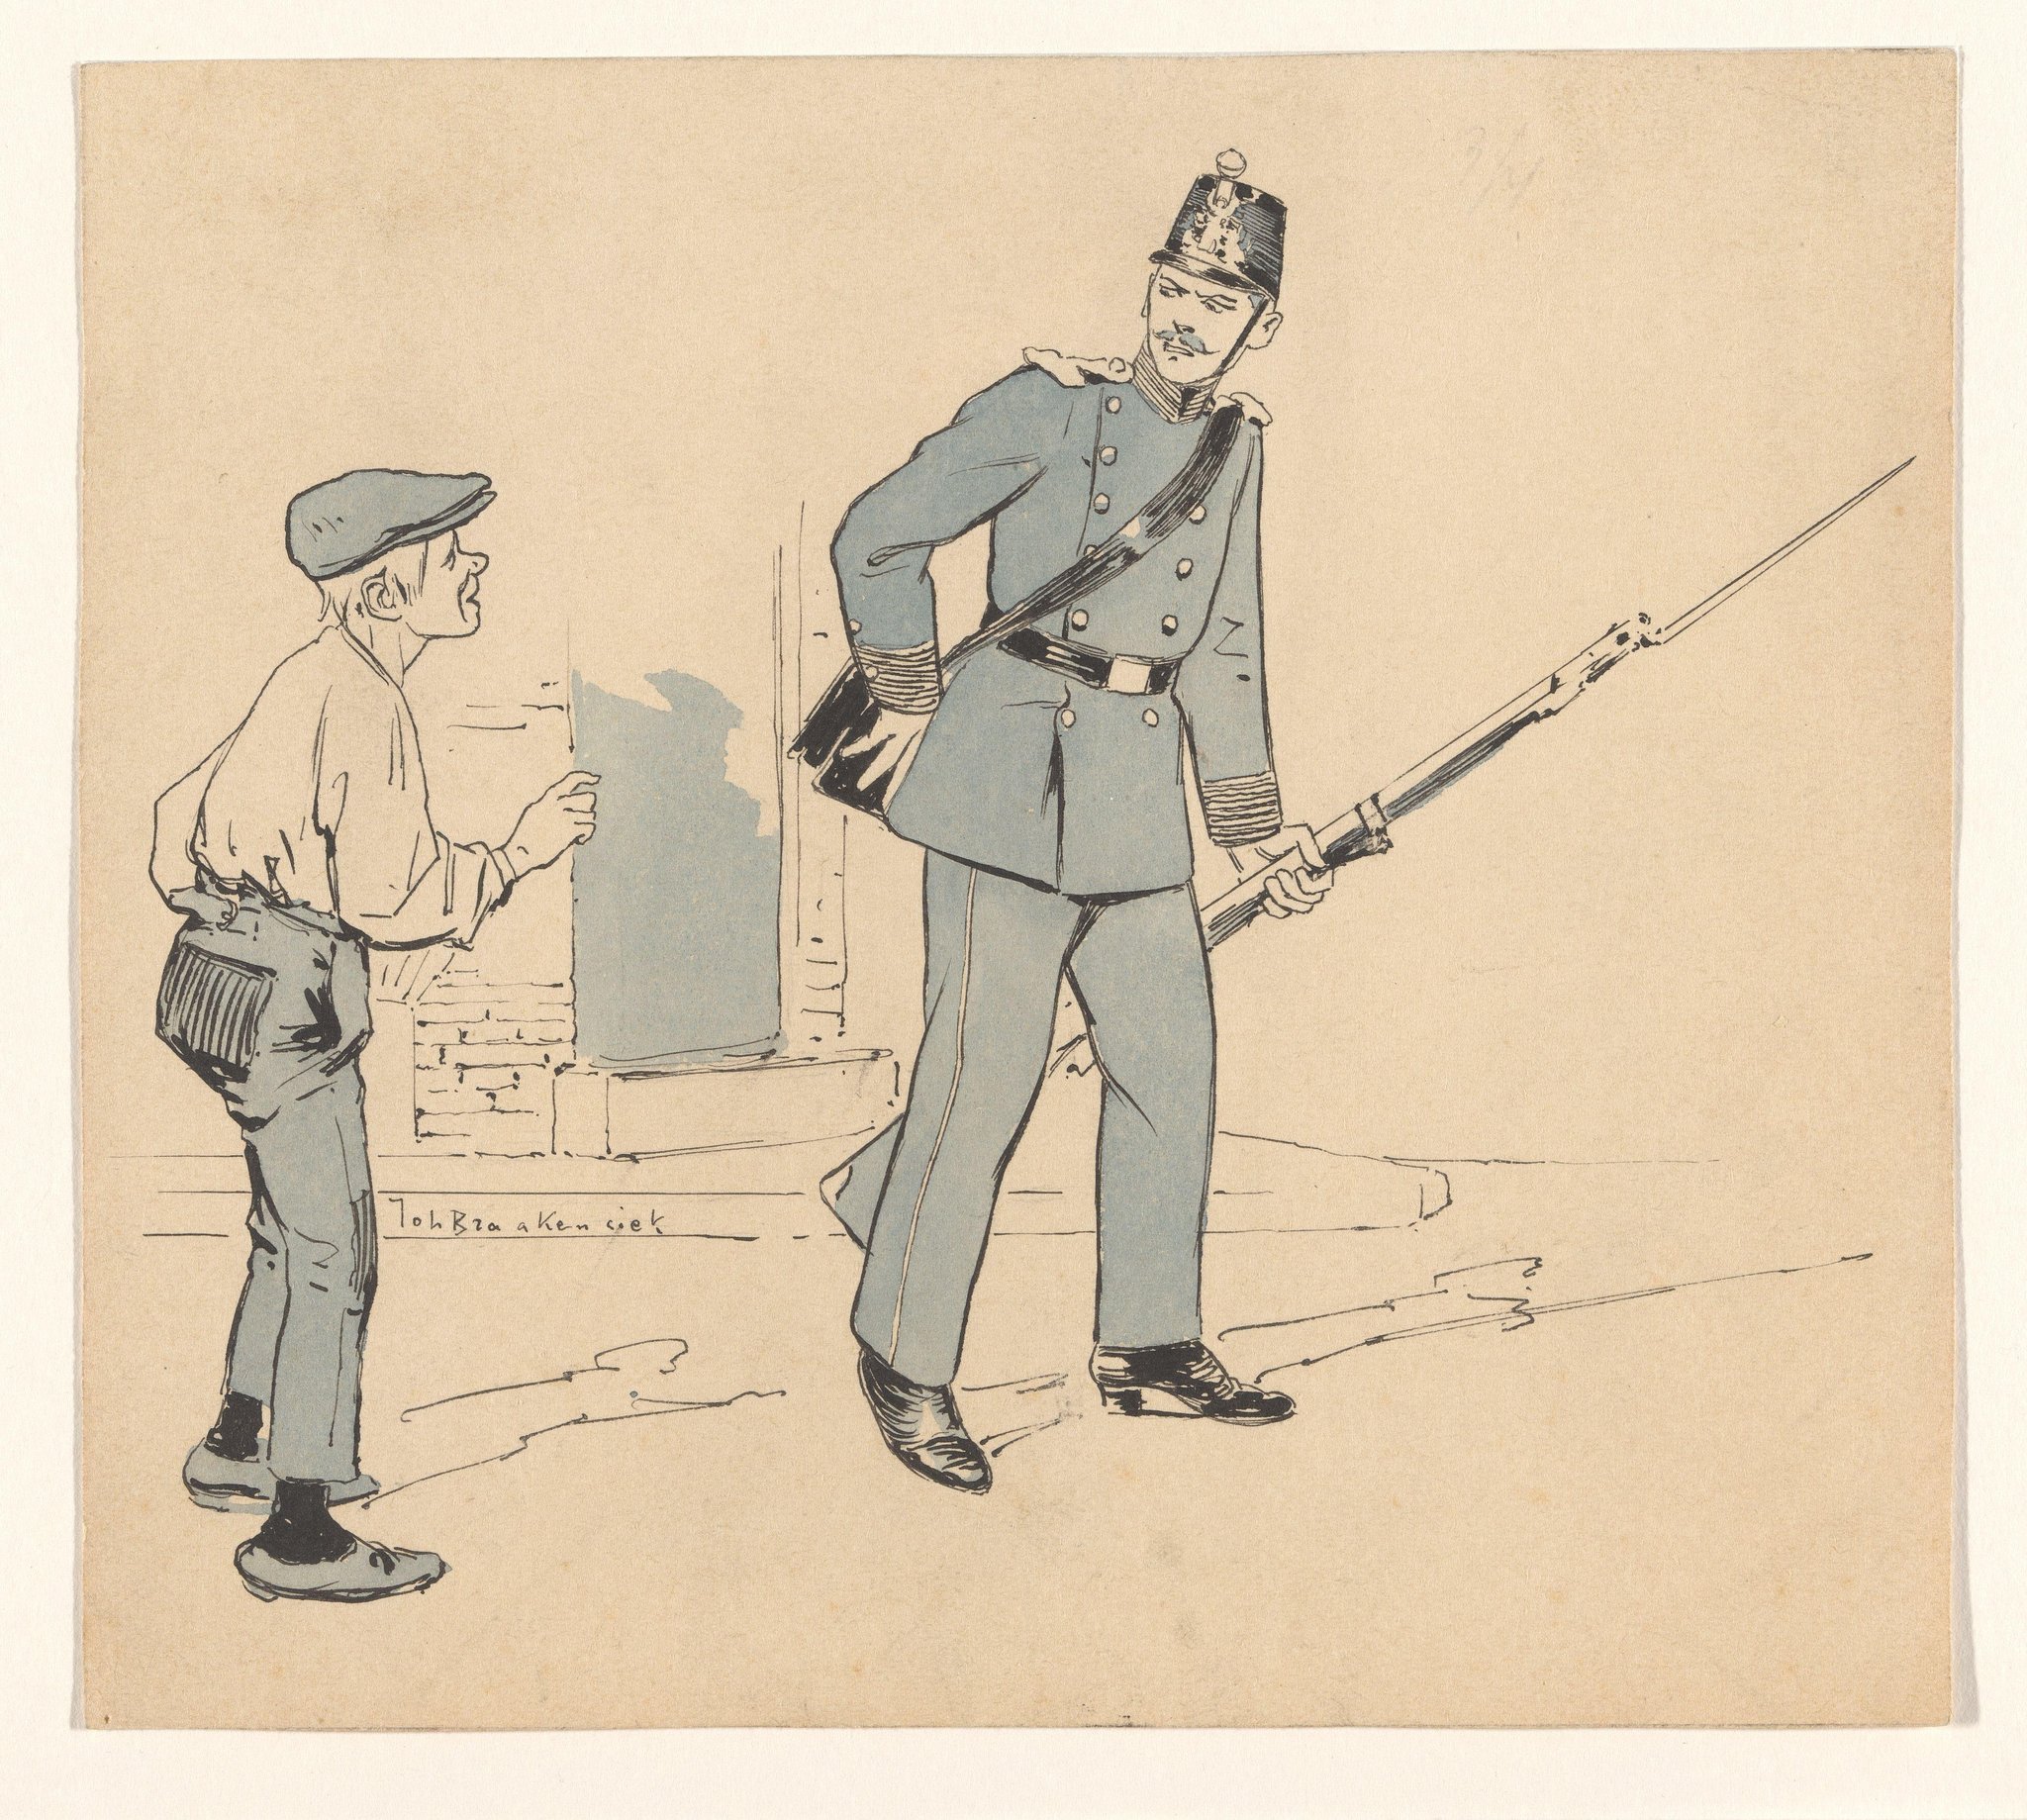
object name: drawing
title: Straatjongen met soldaat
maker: johan braakensiek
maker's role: draughtsman, print maker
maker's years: 1858-1940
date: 1870-1940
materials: ink, paper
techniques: pen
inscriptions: signature: ‘JohBraakensiek’